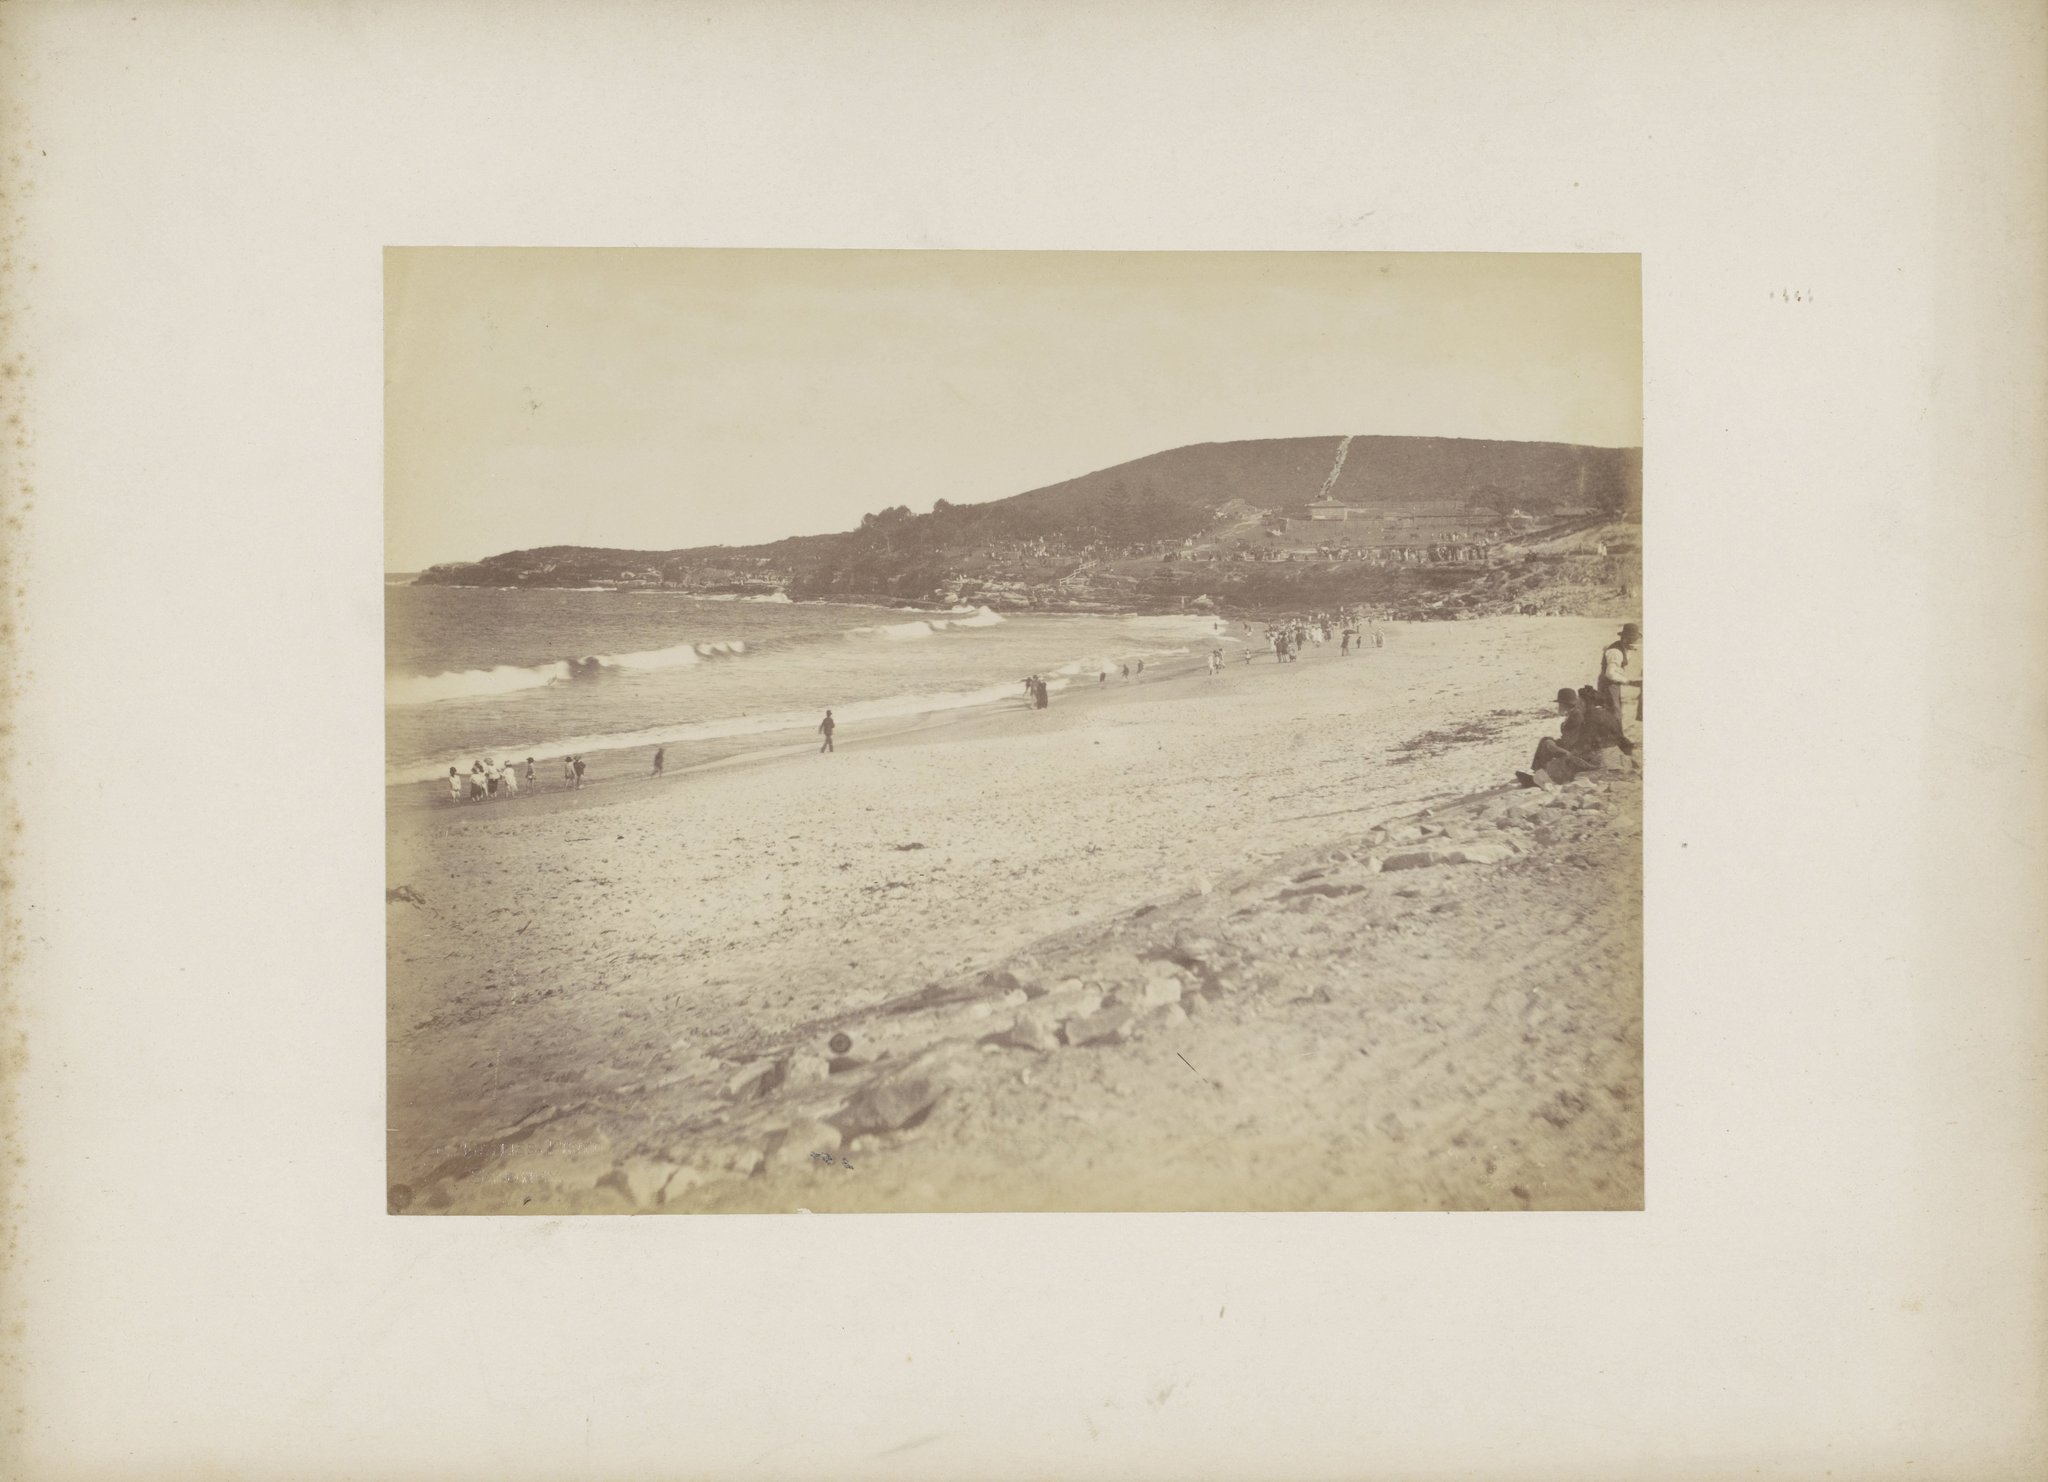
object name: album leaf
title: Badgasten aan een strand, vermoedelijk in Sydney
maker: charles bayliss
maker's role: fotograaf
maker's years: 1850-1897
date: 1890-1910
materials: cardboard, paper, photographic support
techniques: albumen print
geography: sydney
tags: wading, paddling, beach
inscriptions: check stamp: ‘C. Bayliss Photo Sydney’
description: Onderdeel van Reisalbum met foto's van bezienswaardigheden in Sydney.